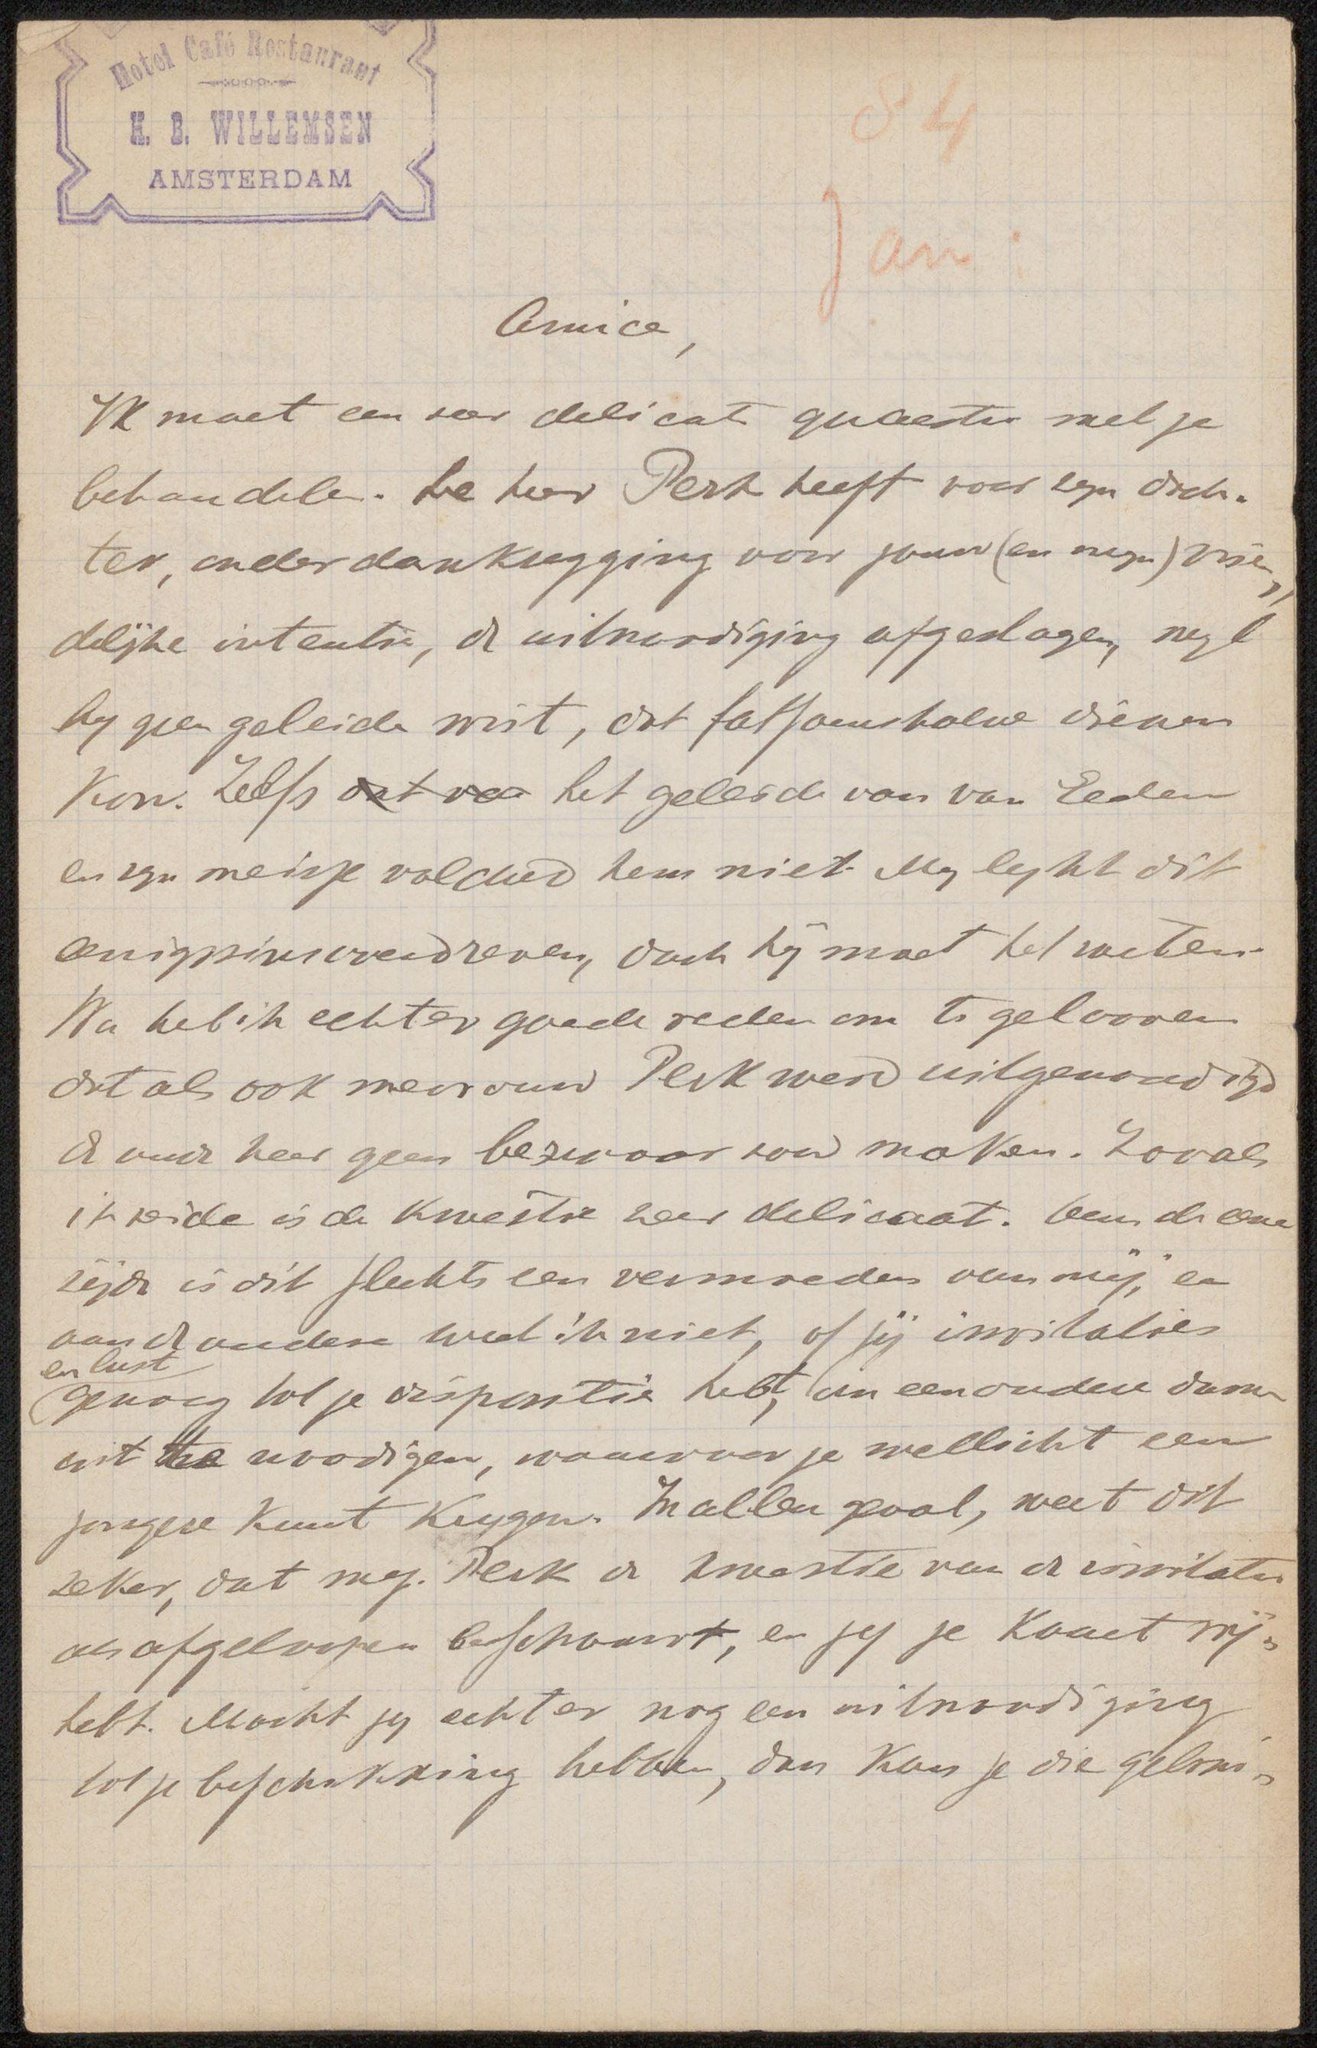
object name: letter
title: Brief aan Jan Veth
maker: chap van deventer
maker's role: kunstcriticus, scheikundige, schrijver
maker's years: 1860-1931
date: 1874-1925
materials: ink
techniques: pen, writing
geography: amsterdam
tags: painter, draughtsman, designer, jan veth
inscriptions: name: ‘Hotel Café Restaurant/ H.B. WILLEMSEN/ AMSTERDAM’, collector's mark: ‘RPK’